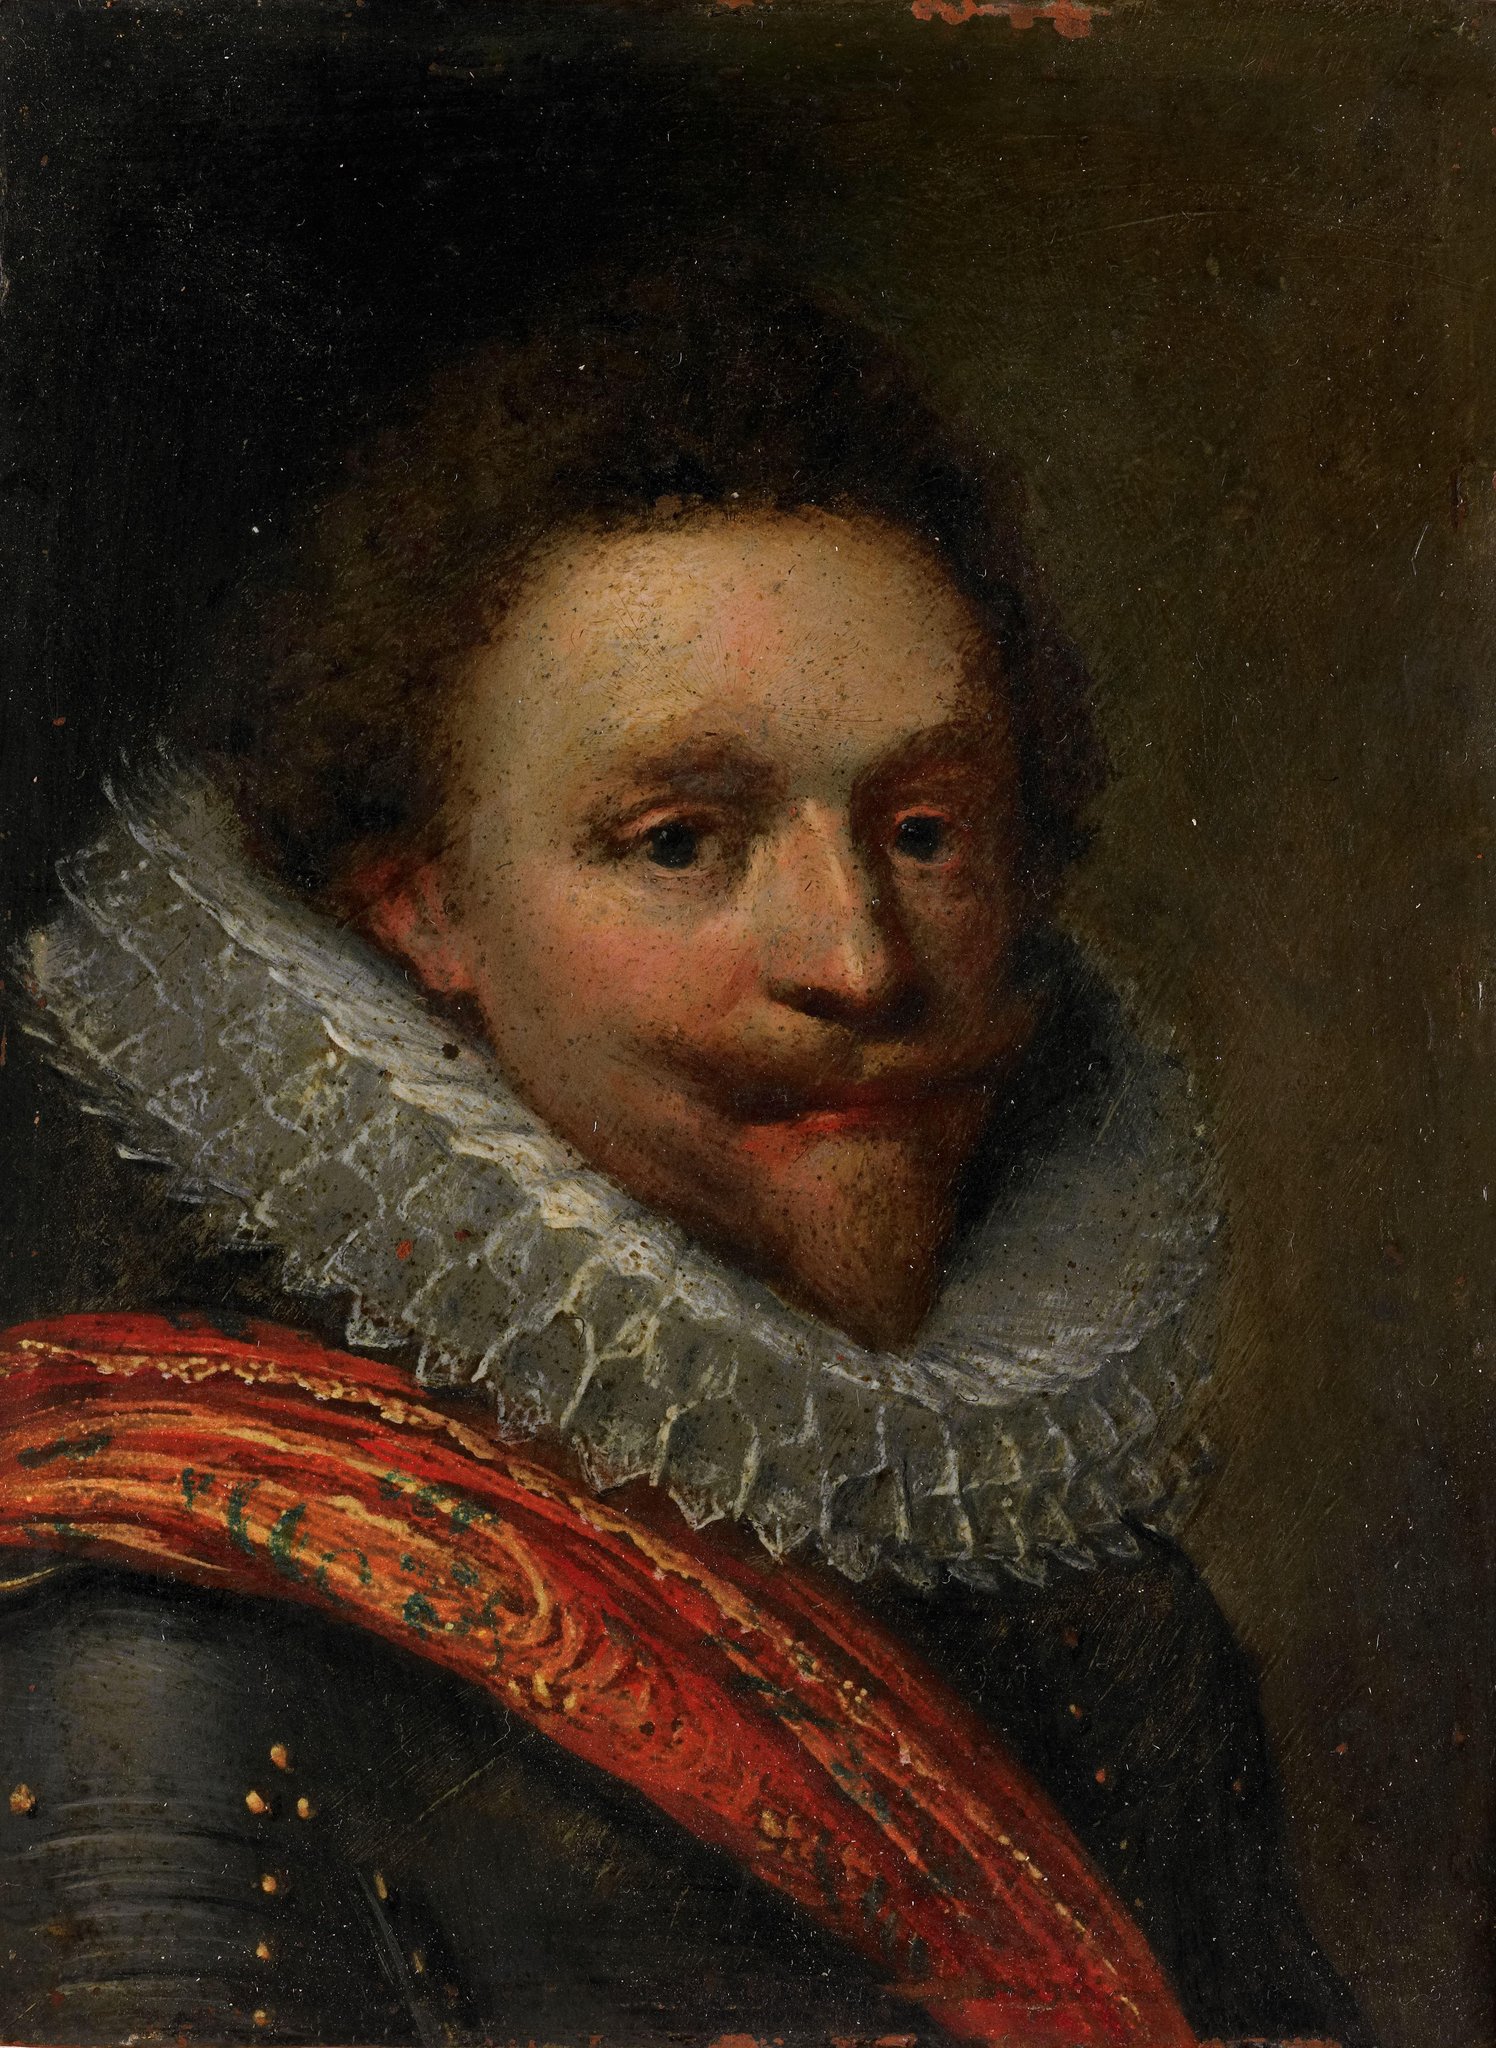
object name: painting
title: Portrait of Frederik Hendrik (1584-1647), Prince of Orange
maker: jacob lyon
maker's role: painter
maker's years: 1586-1659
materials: copper, oil, wood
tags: delft, the hague, frederick henry (prince of orange), prince, historical persons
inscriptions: signature, twice, on the reverse: ‘Jacob Lyon pinx.t / Jacob Lyon ƒ’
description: Portret van Frederik Hendrik, prins van Oranje. Buste naar rechts. Pendant van SK-A-2100.